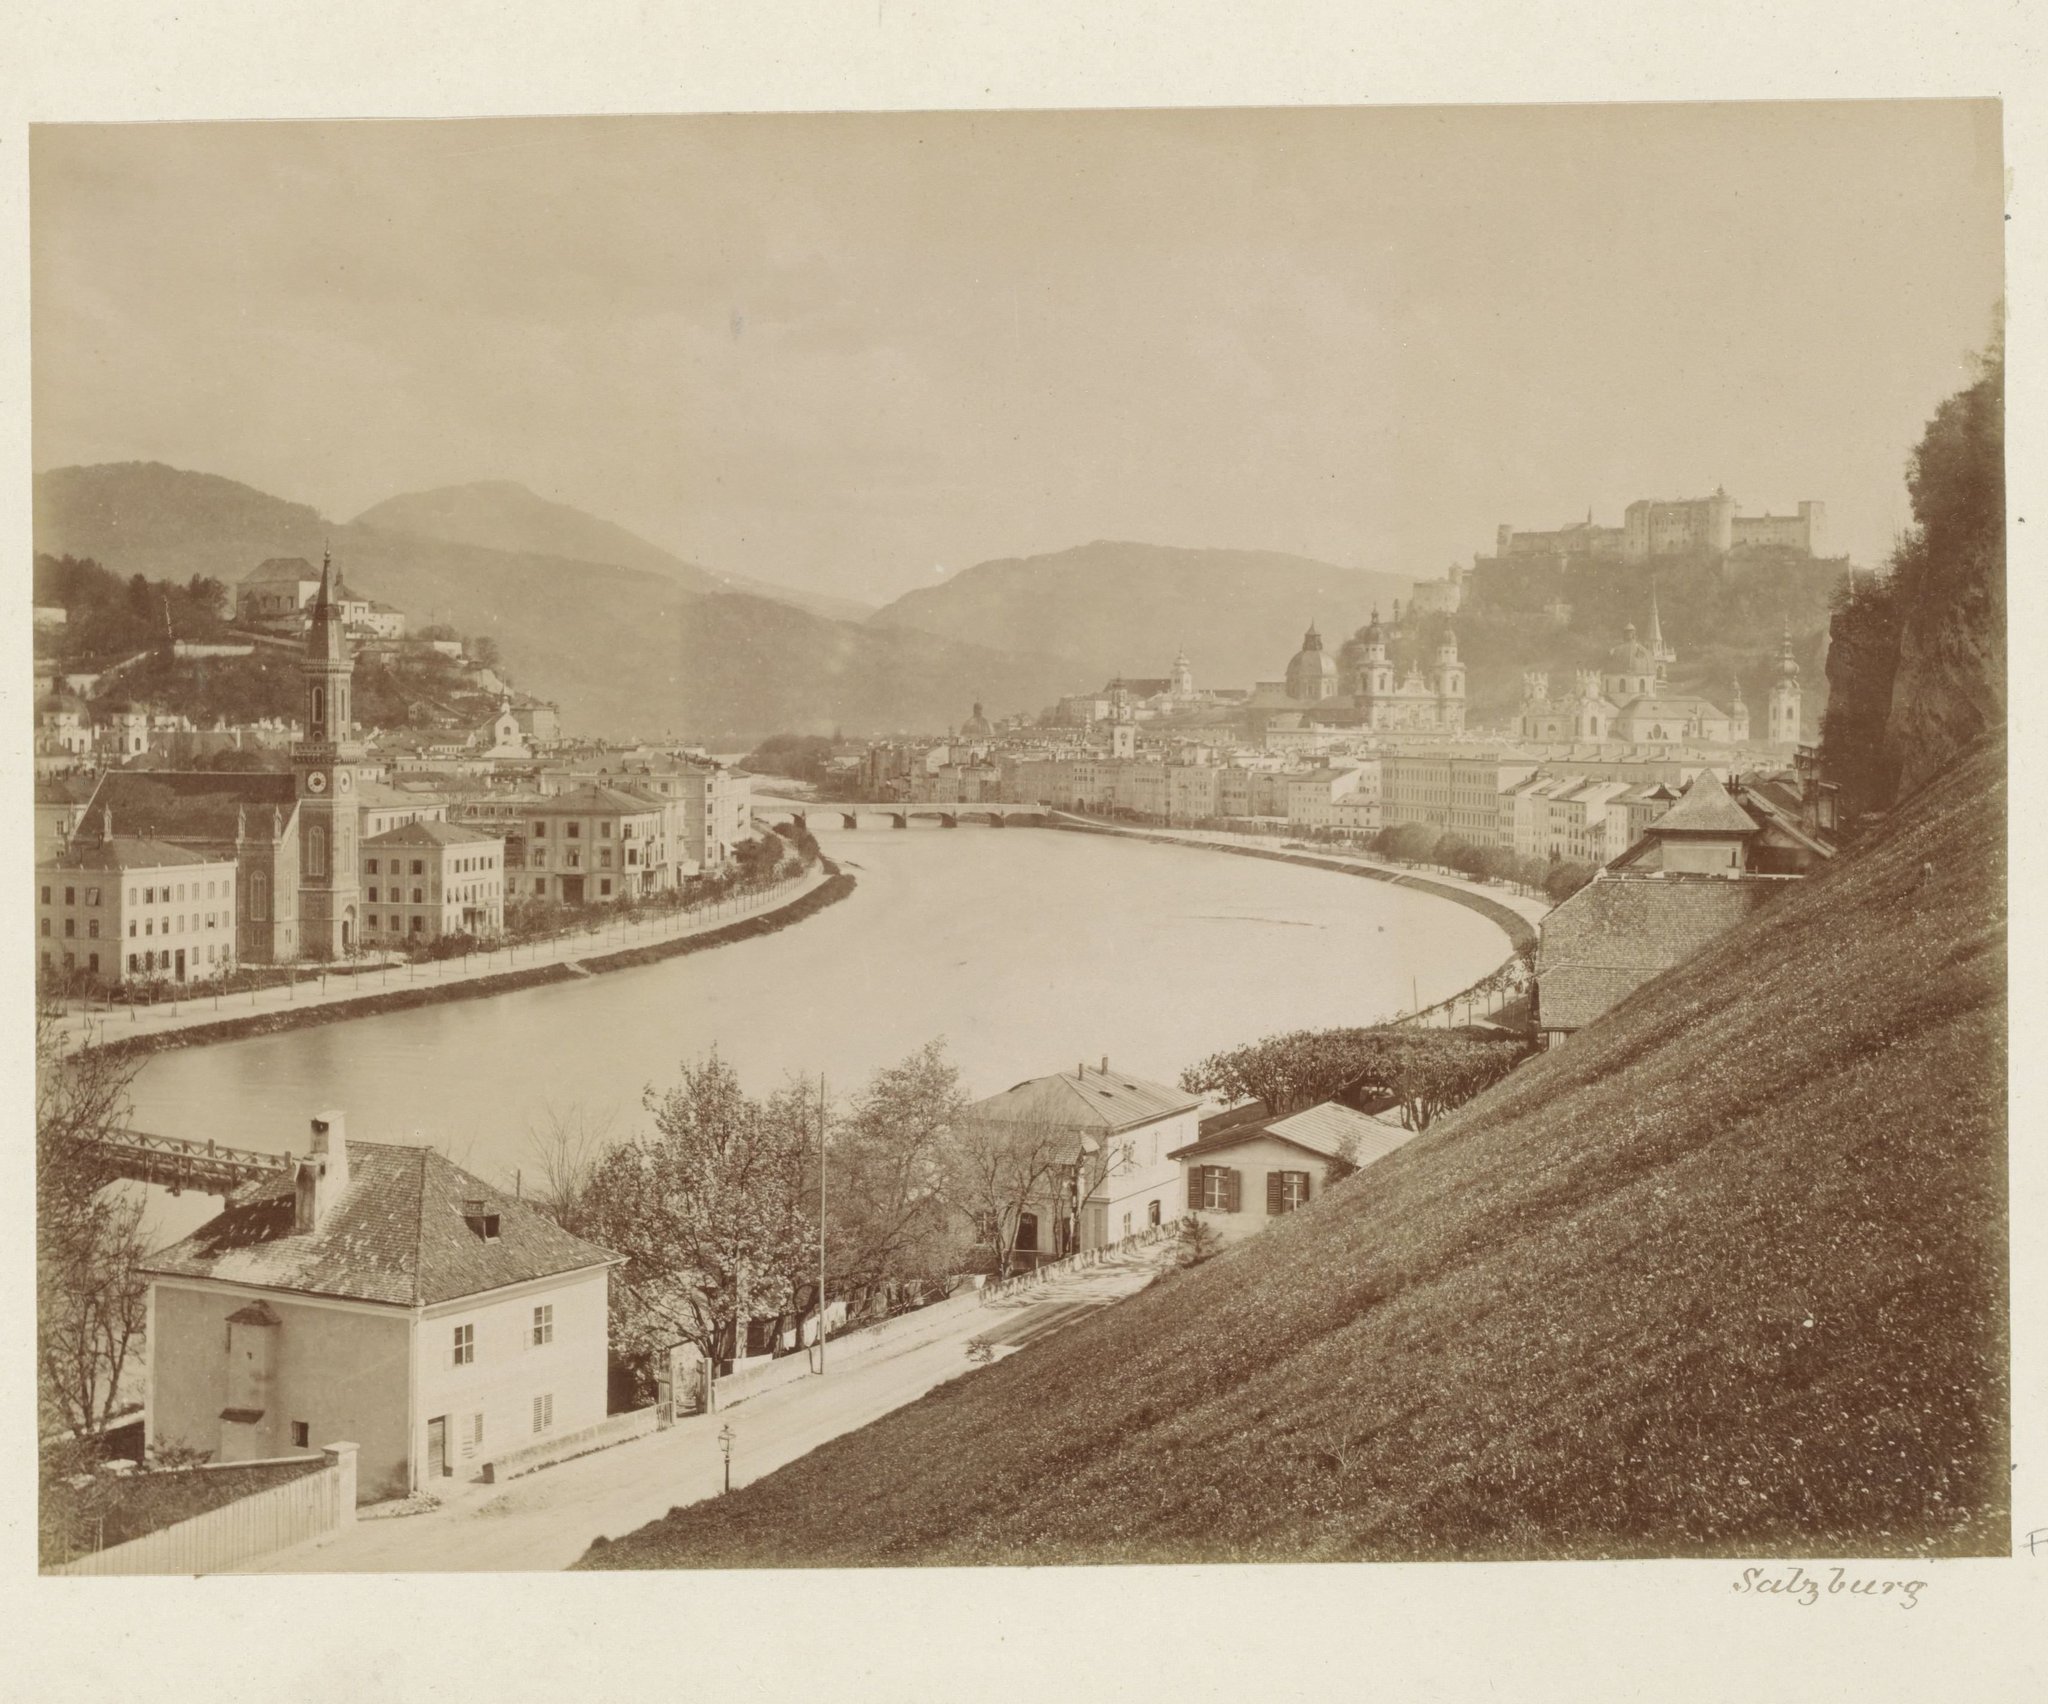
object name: photograph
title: Salzburg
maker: Anonymous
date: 1860-1890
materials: paper, photographic support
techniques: albumen print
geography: drievuldigheidskerk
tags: prospect of city, town panorama, silhouette of city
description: Onderdeel van Reisalbum met foto's van Zwitserland, Oostenrijk, Italië en Duitsland.